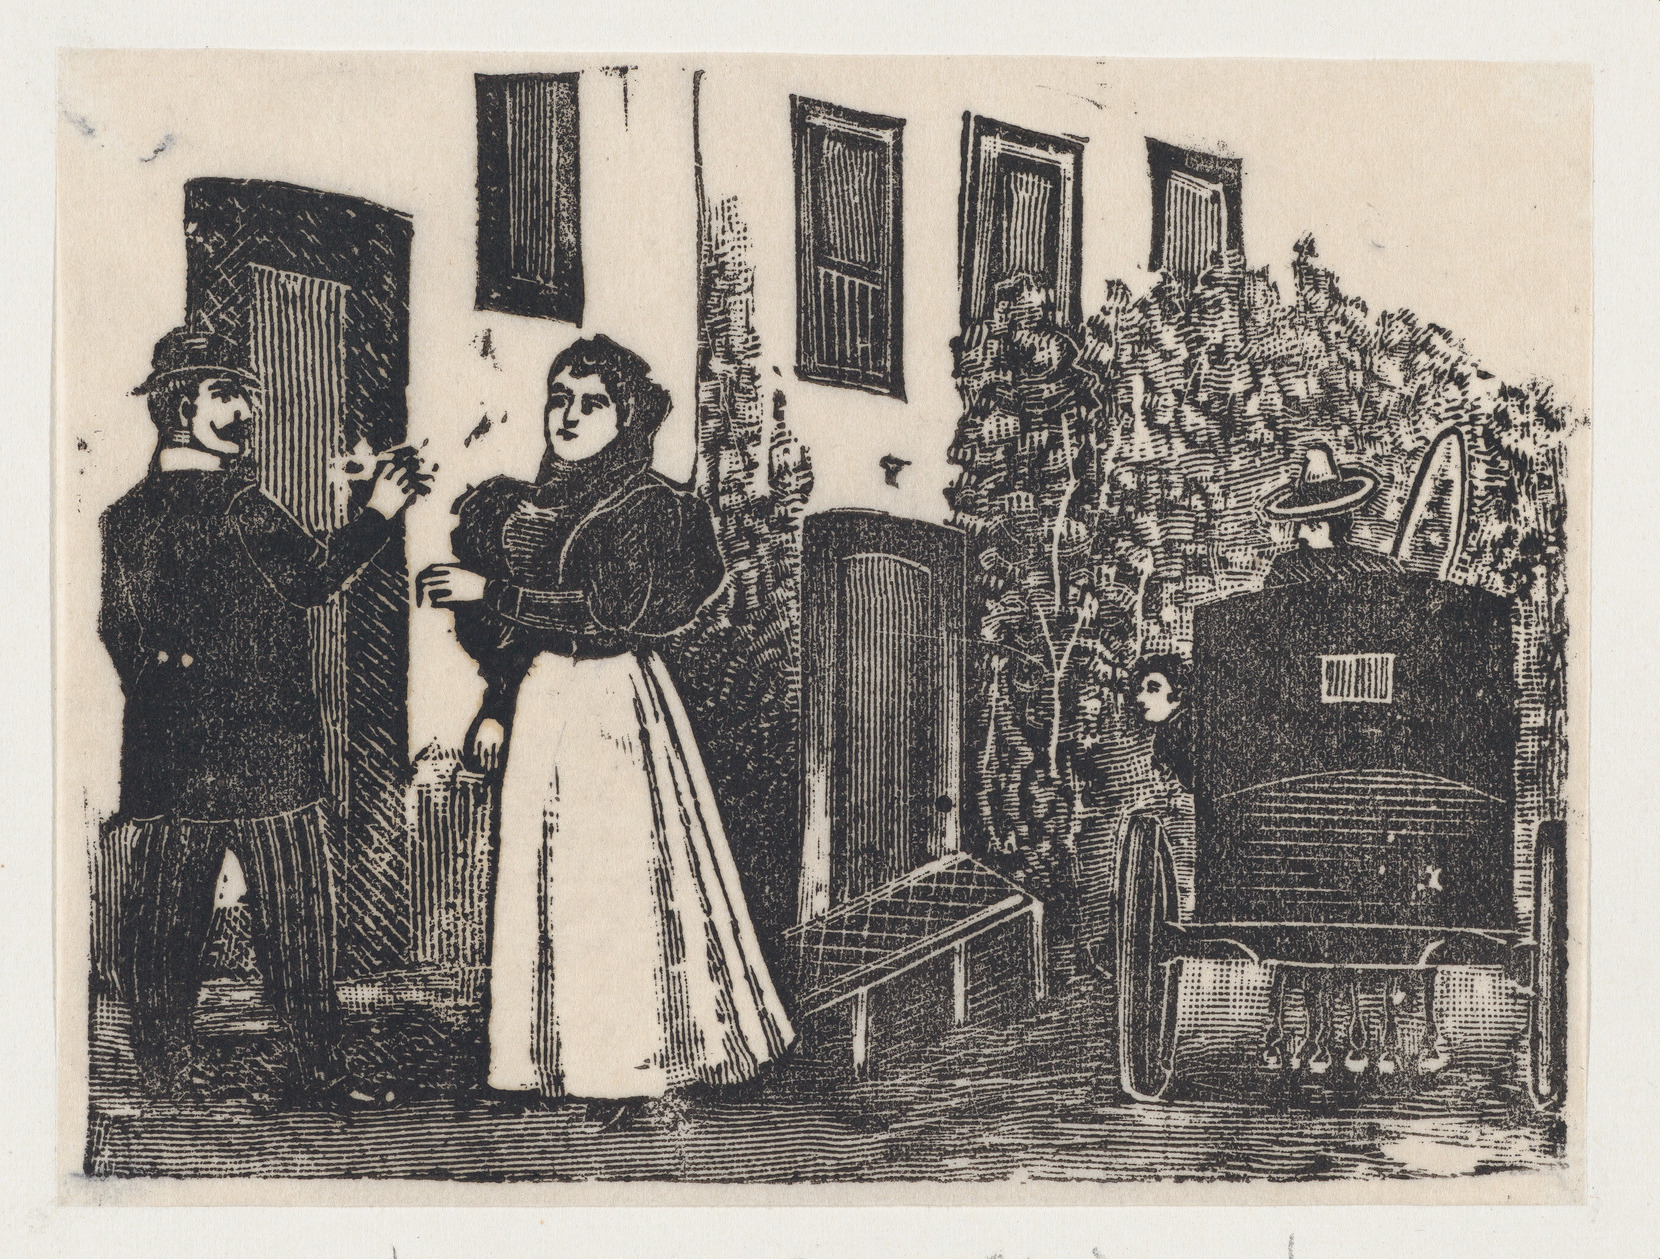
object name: print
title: A middle-class couple (Maria la chiquita) outside a house with a waiting coach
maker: josé guadalupe posada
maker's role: artist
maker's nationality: mexican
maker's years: 1852-1913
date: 1880-1910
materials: metal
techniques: engraving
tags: men,women,carriages